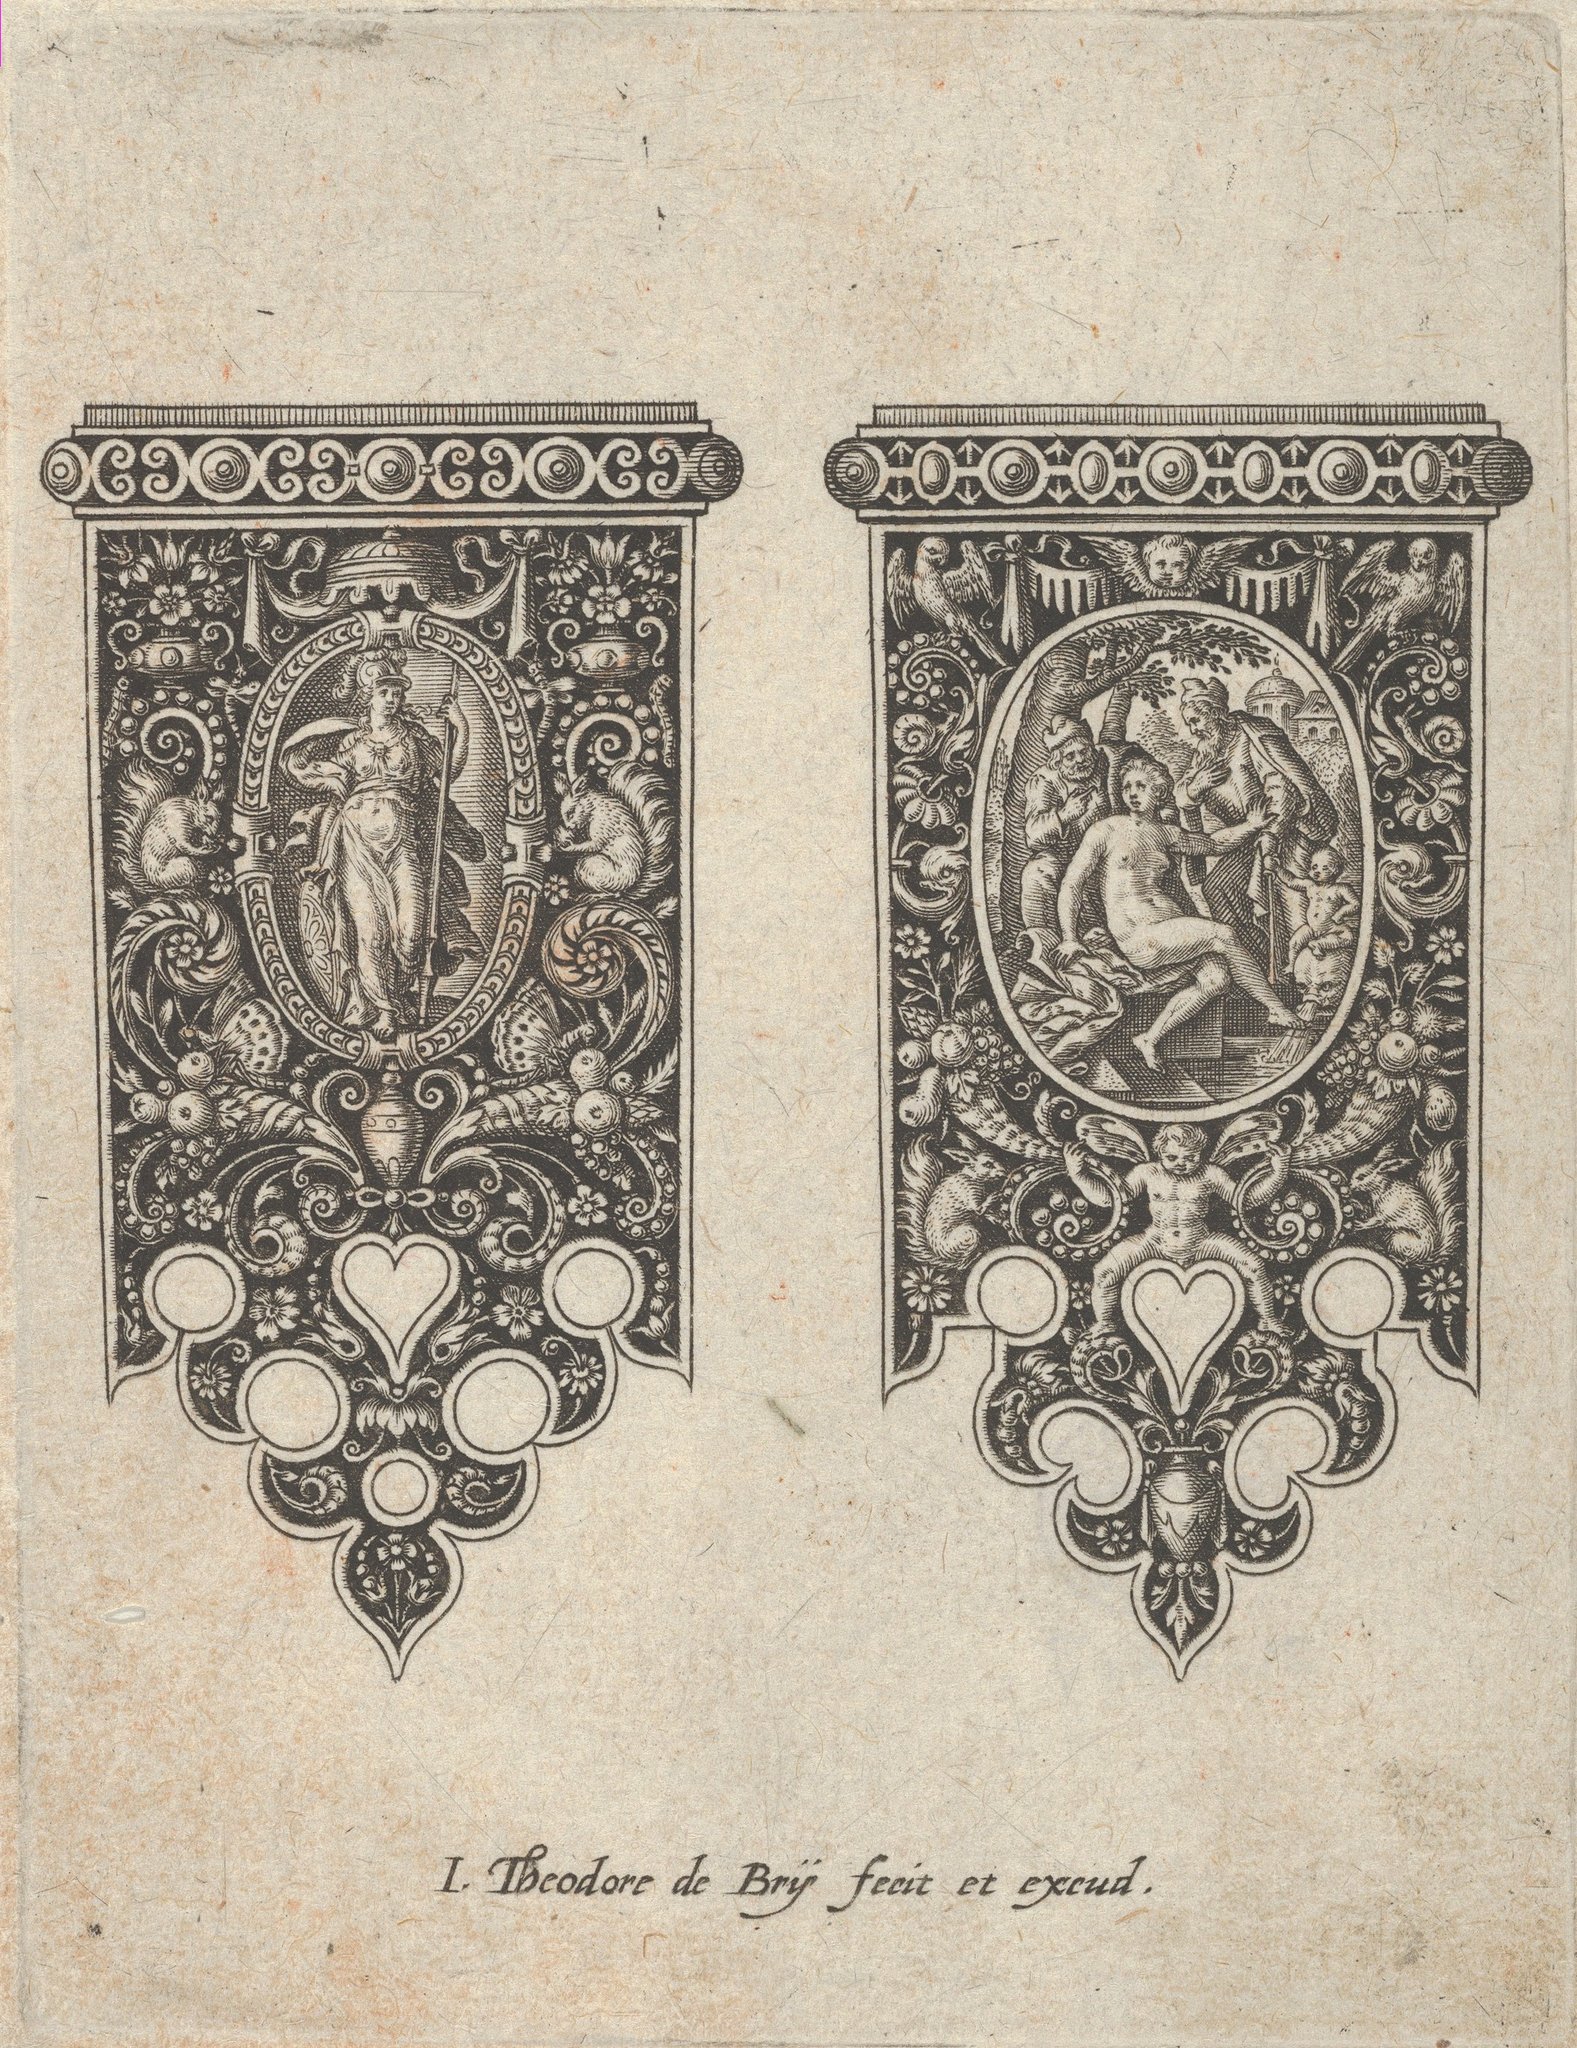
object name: print ornament architecture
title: Design for Knife Handles with an Armed Woman and Susanna and the Elders, from Mansches de Coutiaus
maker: johann theodor de bry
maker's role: artist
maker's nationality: netherlandish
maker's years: 1561-1623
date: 1580-1600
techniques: embroidery, engraving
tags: animals,ornament,children,men,women